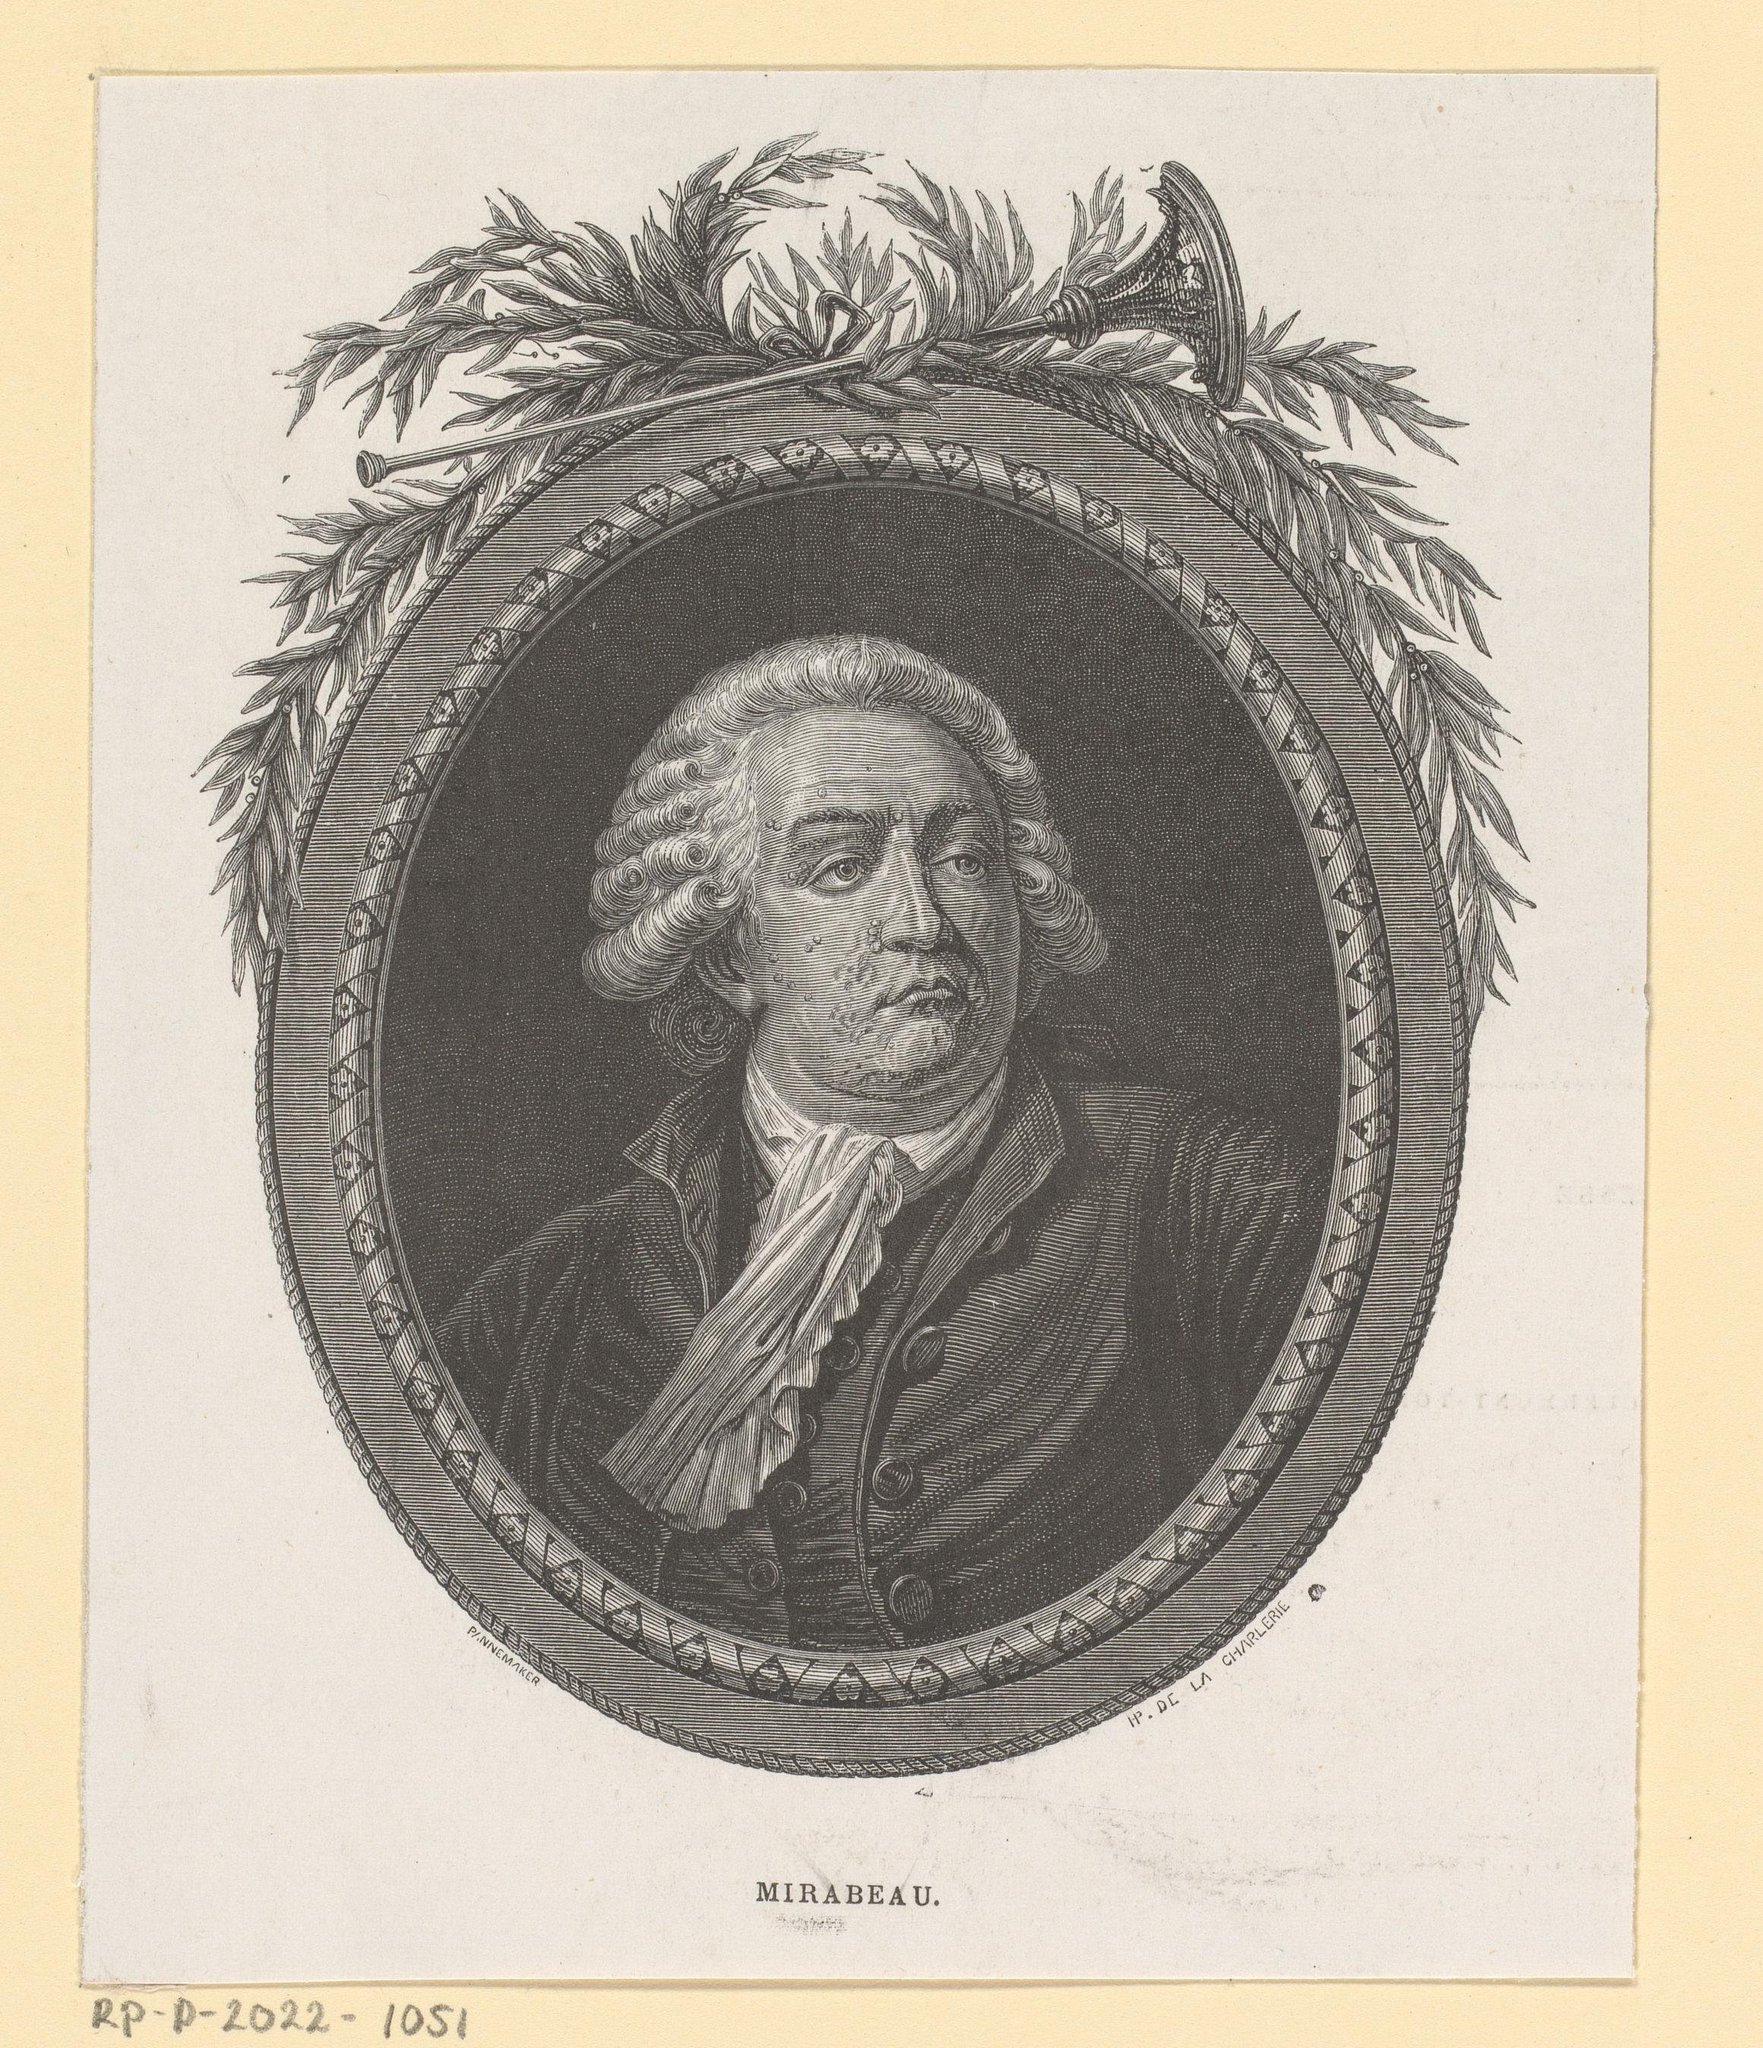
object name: print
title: Mirabeau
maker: hippolyte charlerie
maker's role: draughtsman, print maker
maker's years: 1827-1869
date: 1800-1900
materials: paper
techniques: letterpress printing, engraving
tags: paris, politician, honoré-gabriel de riqueti (graaf van mirabeau), historical persons, ambassador